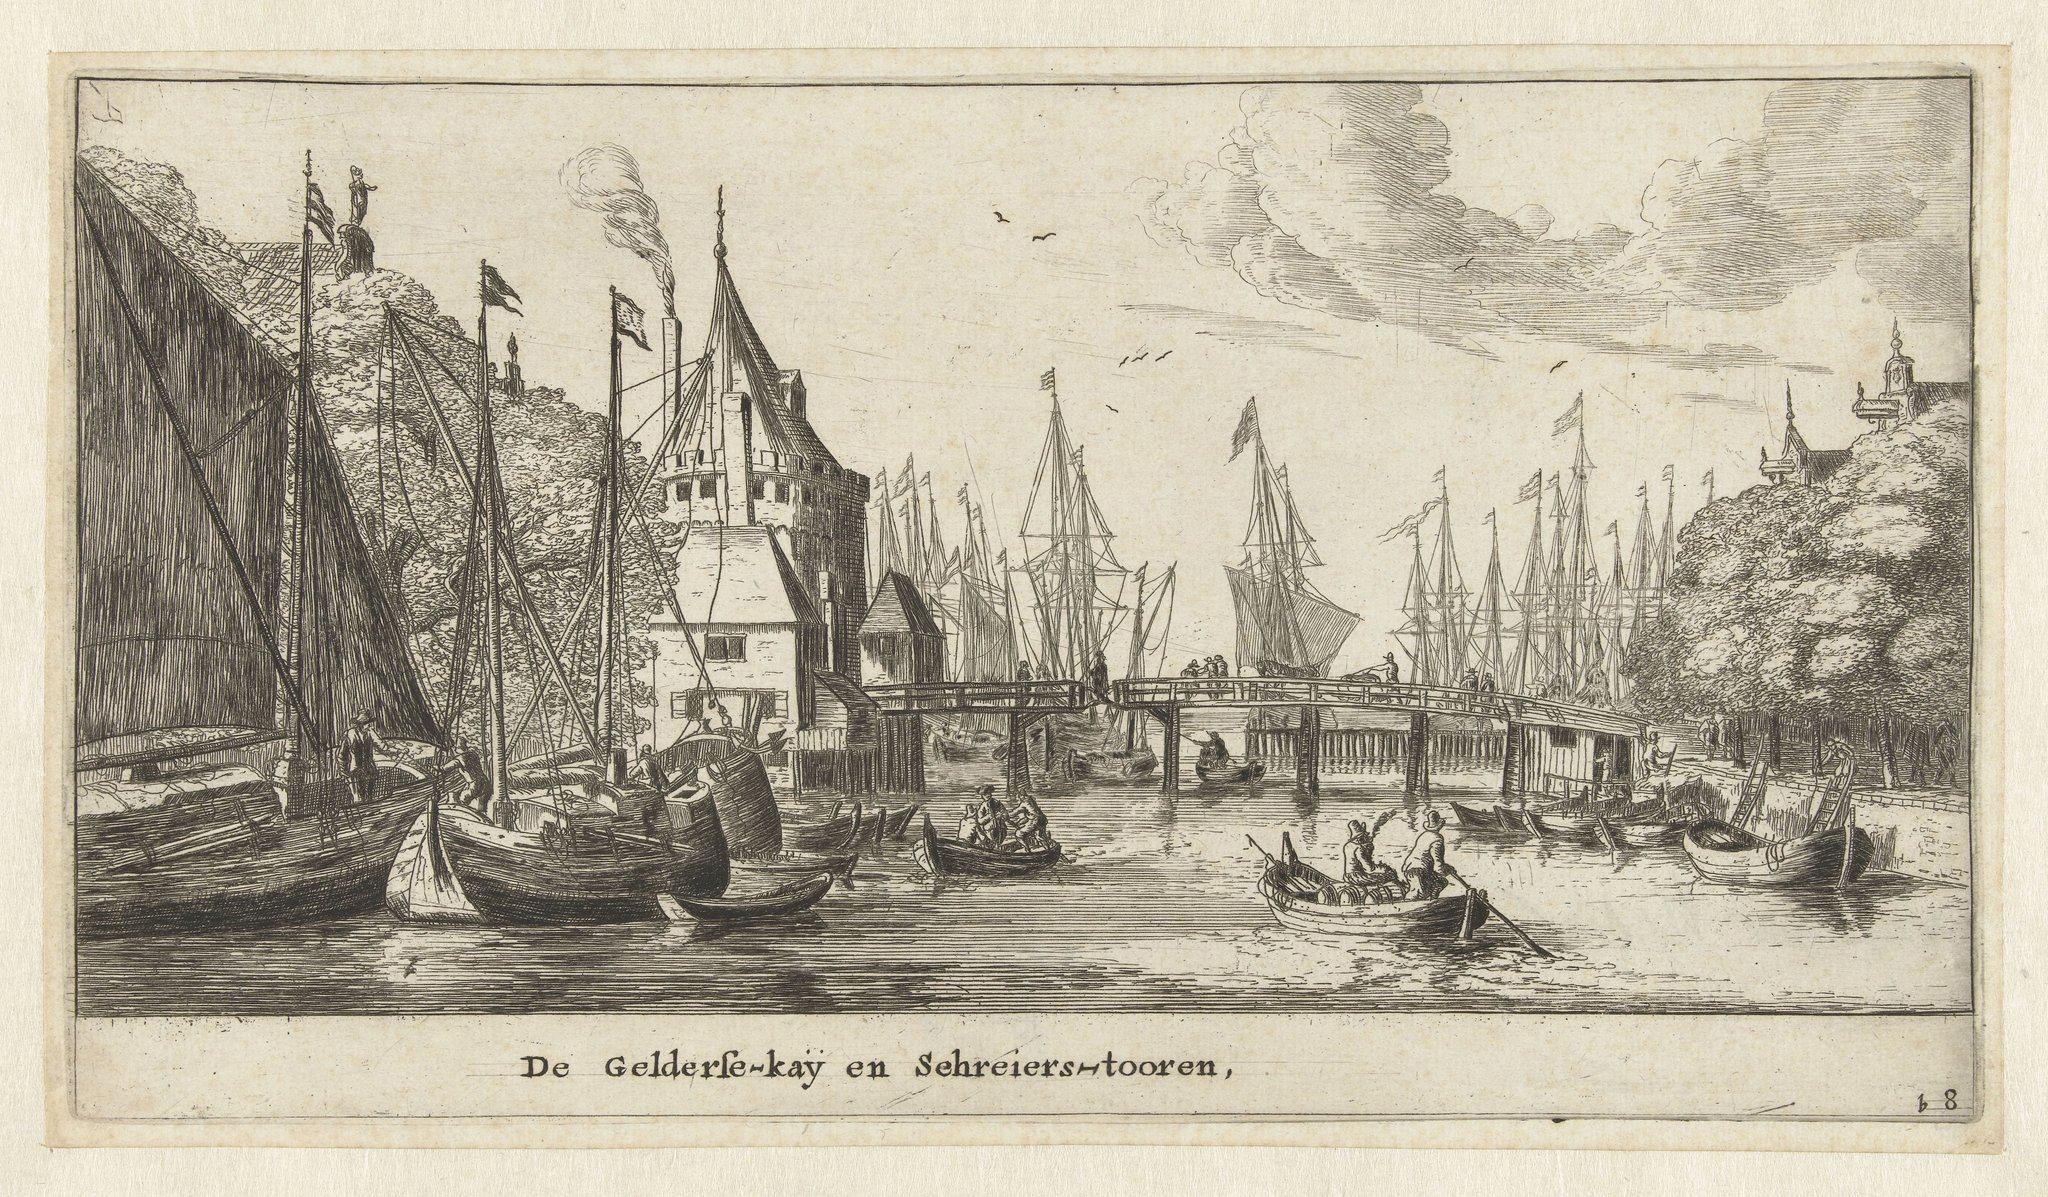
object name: print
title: Verschillende schepen en stadsgezichten van Amsterdam, tweede deel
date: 1652-1654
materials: paper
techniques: drypoint, etching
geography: netherlands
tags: ships (in general)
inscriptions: collector's mark: Lugt 2228, collector's mark: Lugt 1494, collector's mark: Lugt 1227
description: De Gelderse Kade, de Schreierstoren en de brug over het water. Vele schepen in het water.